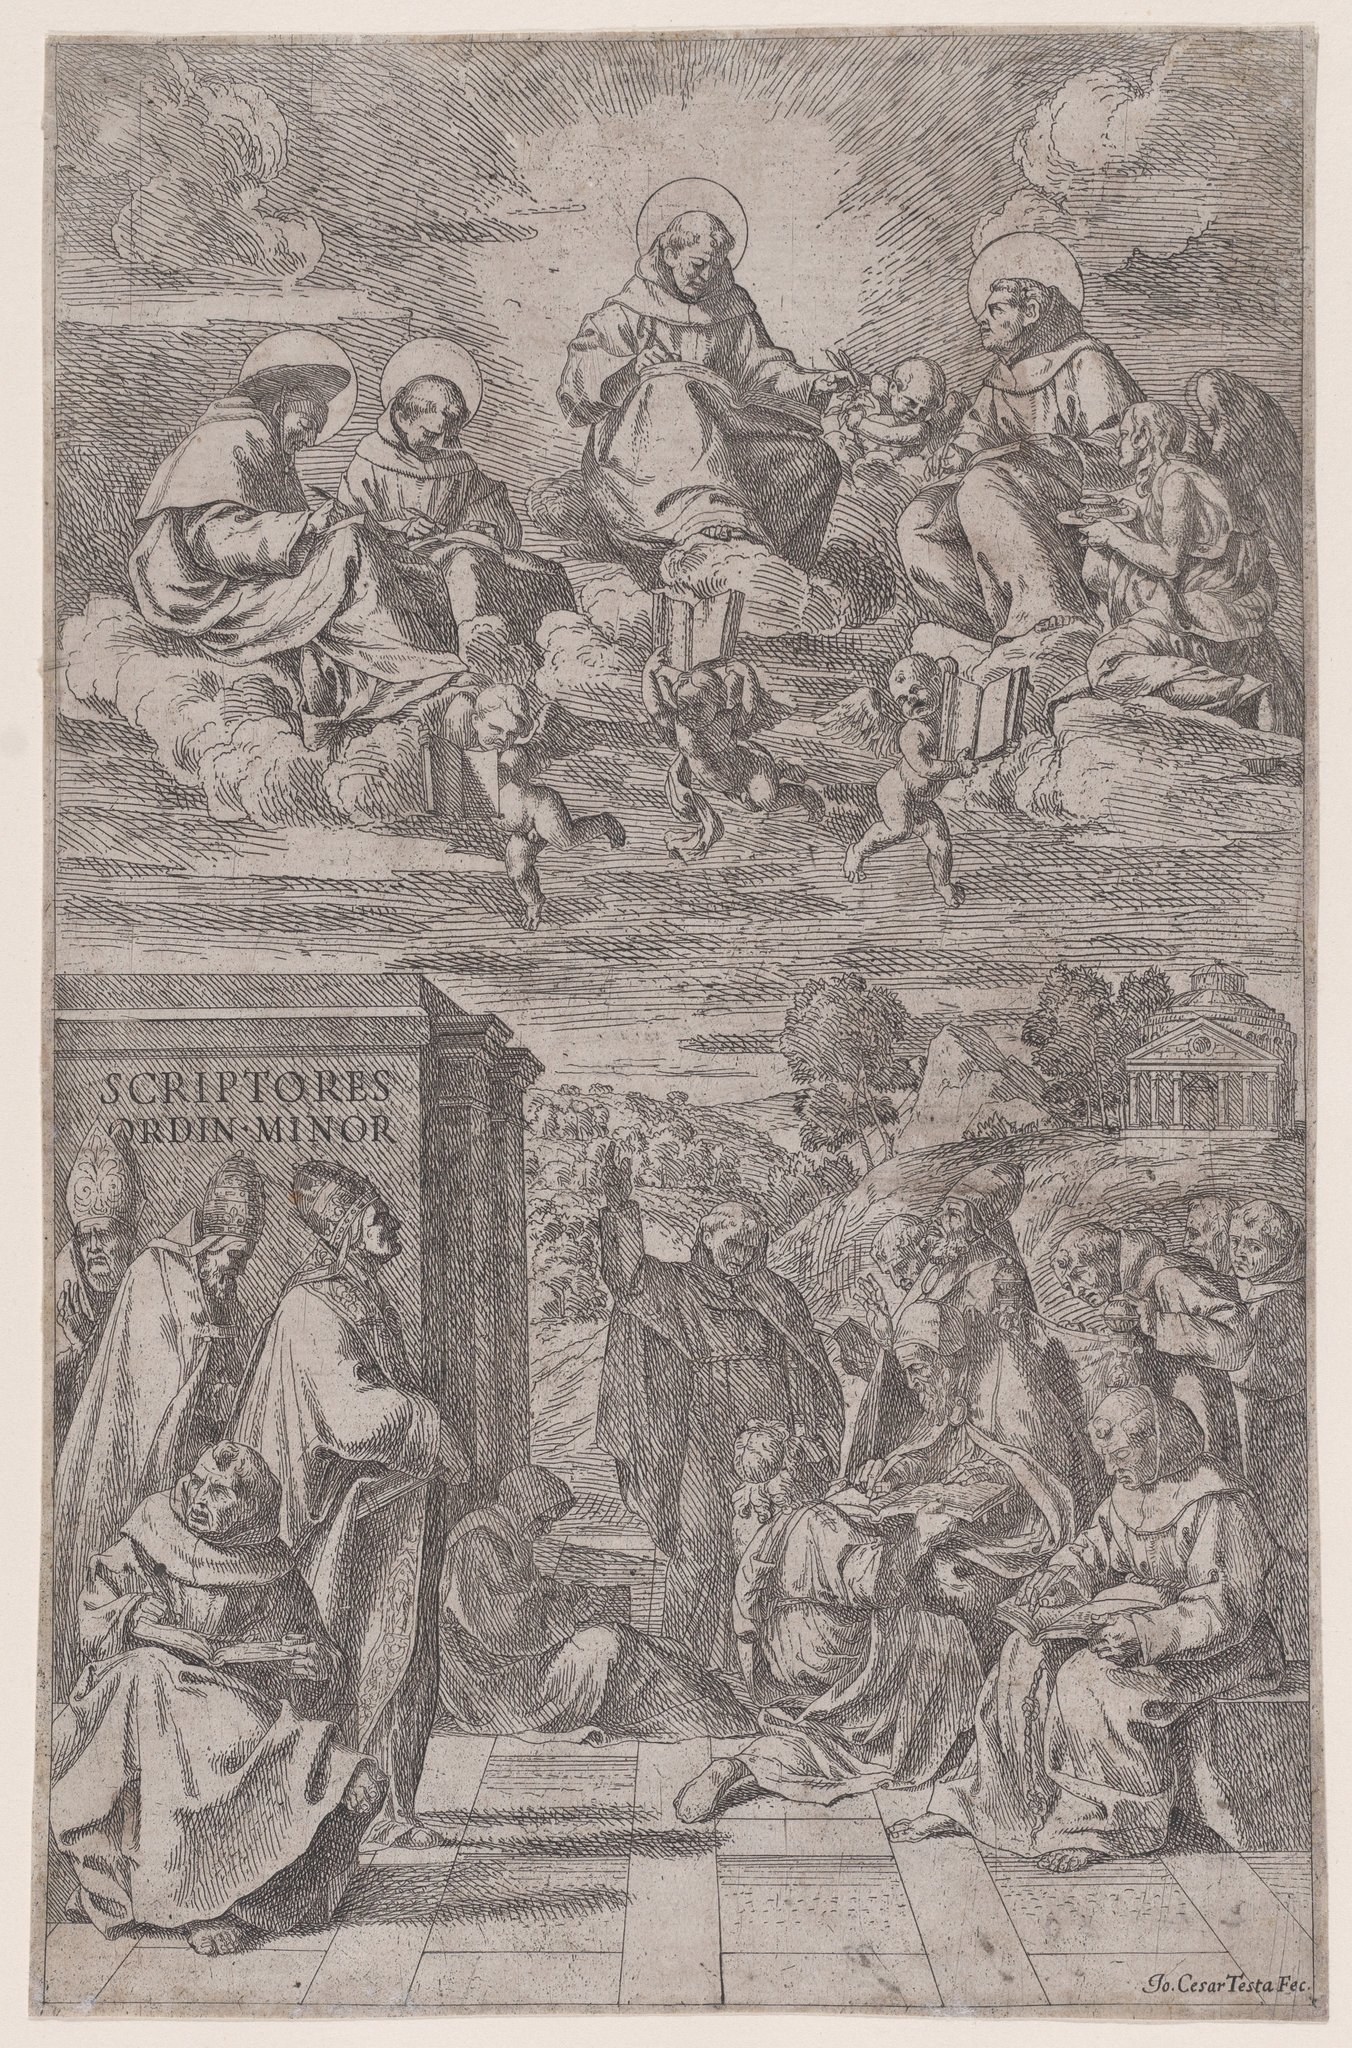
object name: print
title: Ecclesiastics in a landscape writing, other in the heavenly realm above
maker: giovanni cesare testa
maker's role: artist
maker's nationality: italian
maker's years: 1630-1655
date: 1601-1700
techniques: etching